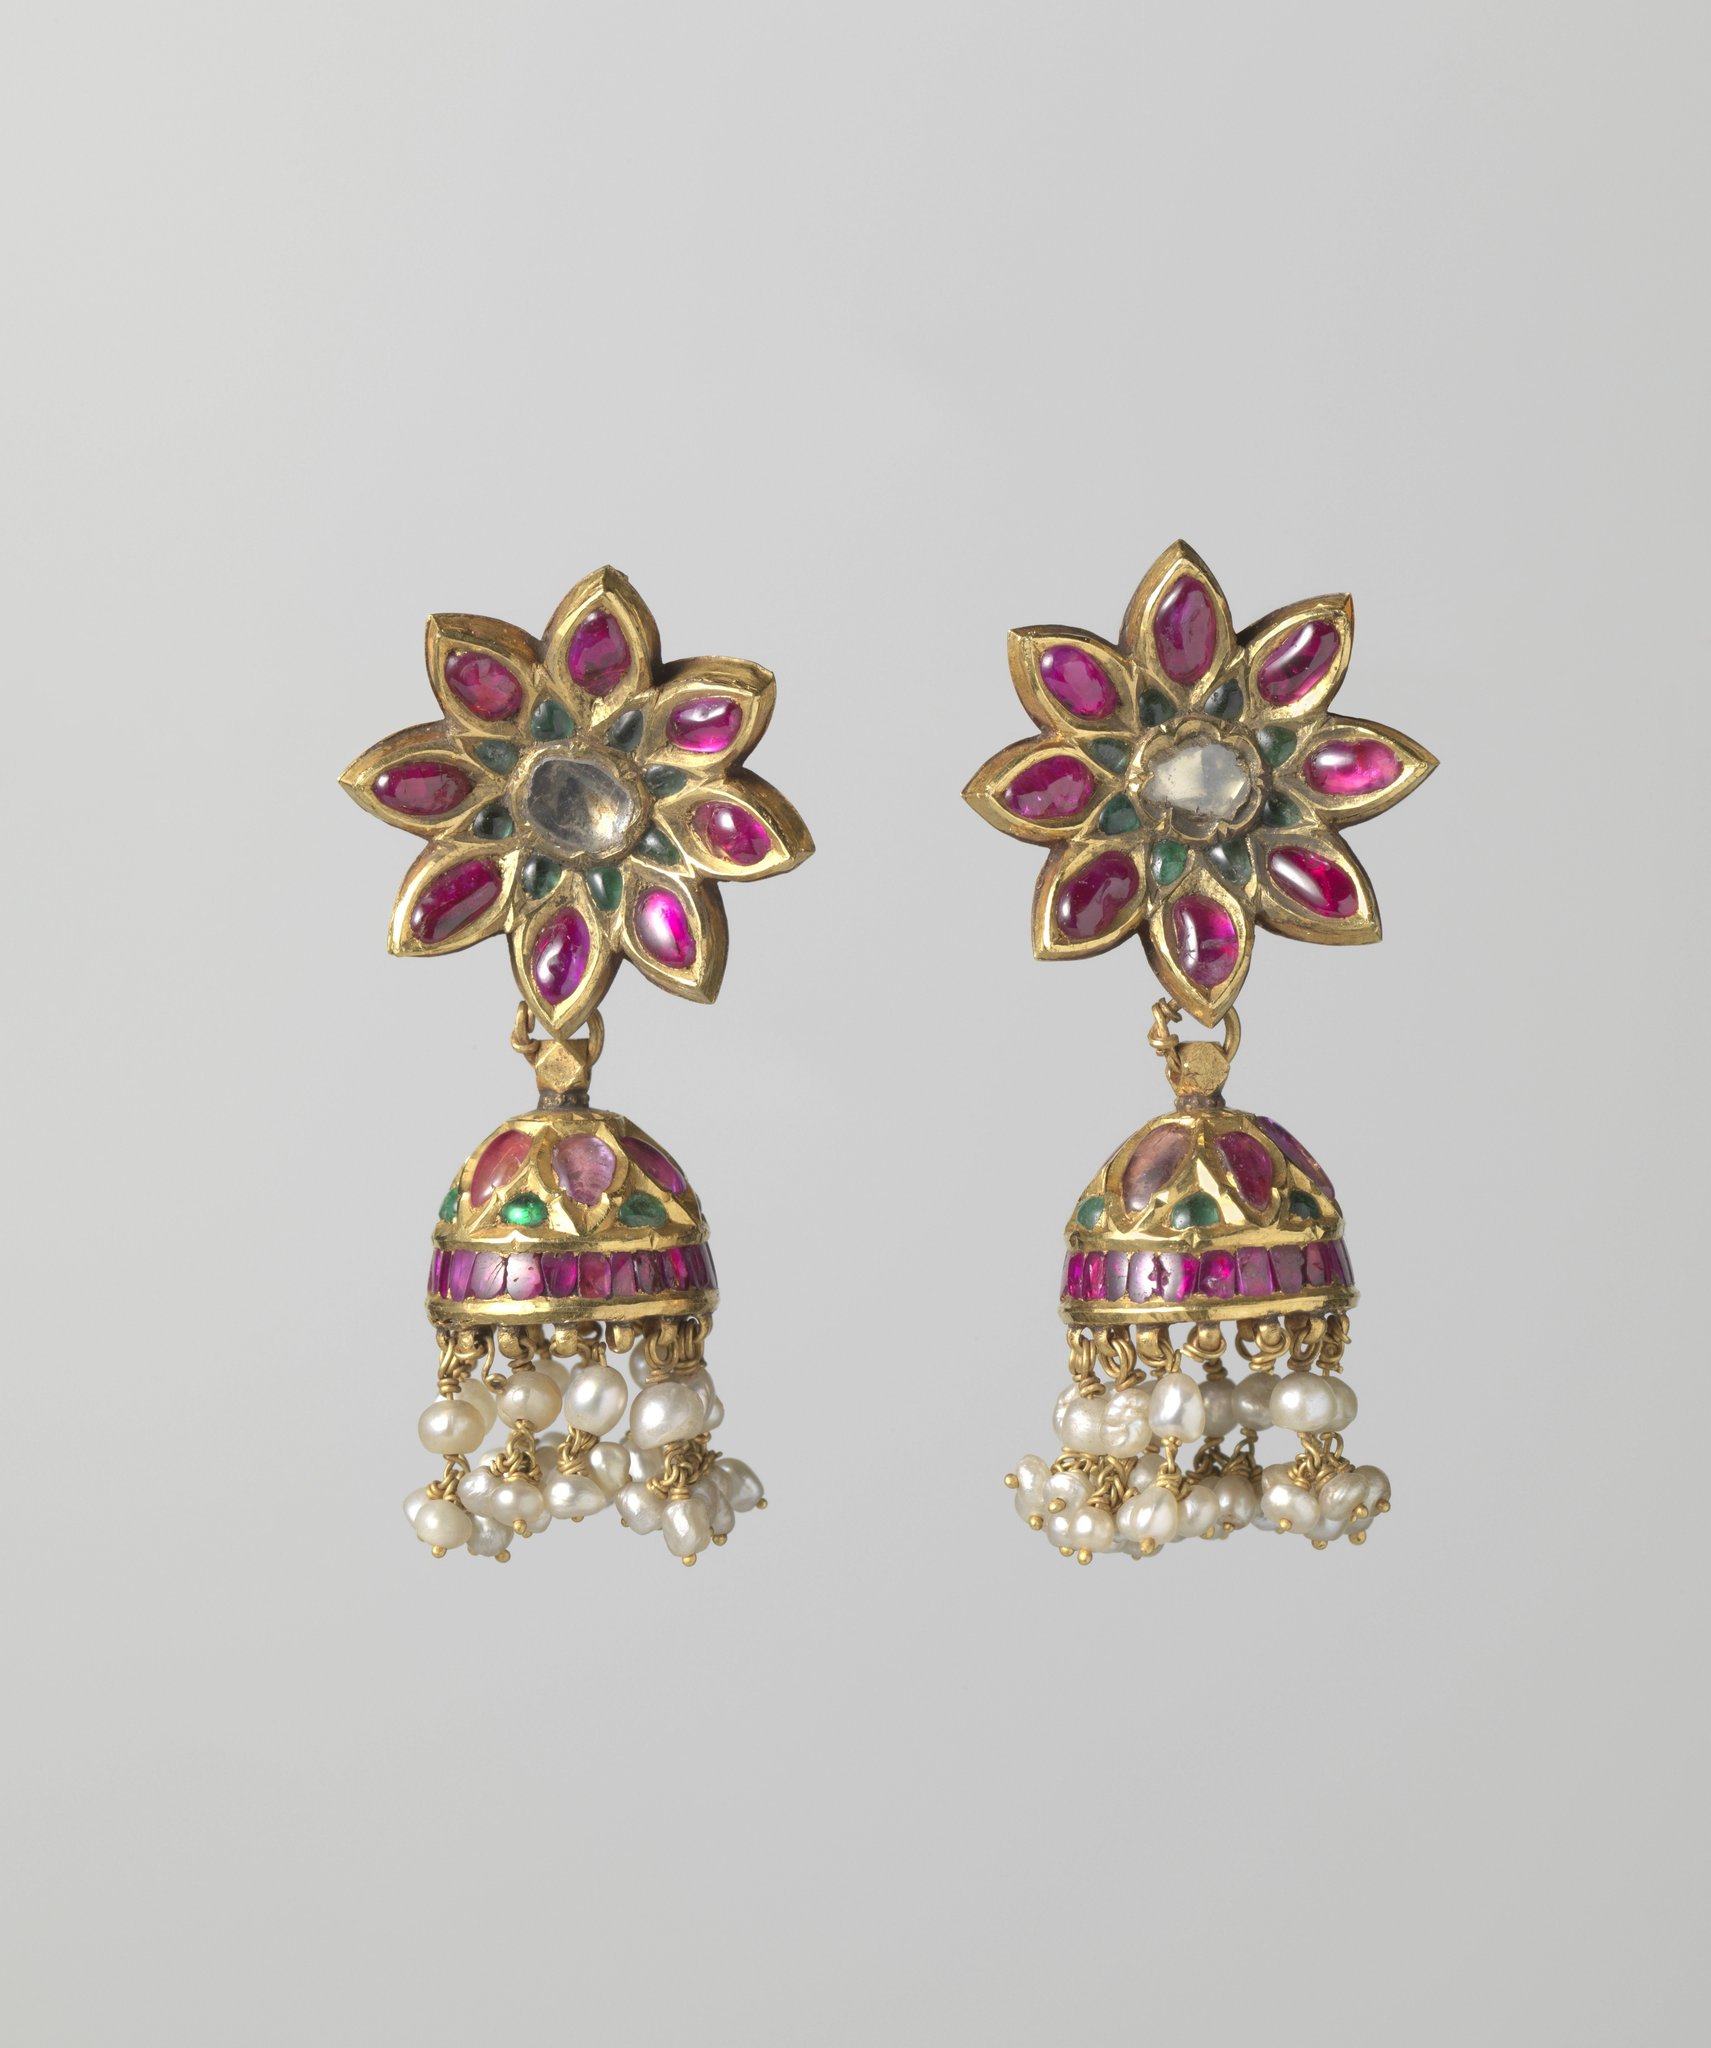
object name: earring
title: Pair of earrings (phuljhumka)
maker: Anonymous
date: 1750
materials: diamond, gold, pearl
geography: surat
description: These jewels are part of an ensemble collected by Julius Stein van Gollenesse, director-general of the VOC (Dutch East India Company) in Batavia (now Jakarta). Attached to the top of the ornament in the shape of a horizontal crescent moon is a tiny eye. A pearl necklace would have been affixed to it, and the jewel then pinned in the hair so that it would fall in the middle of the forehead. The round ornament was worn on the side of the head.